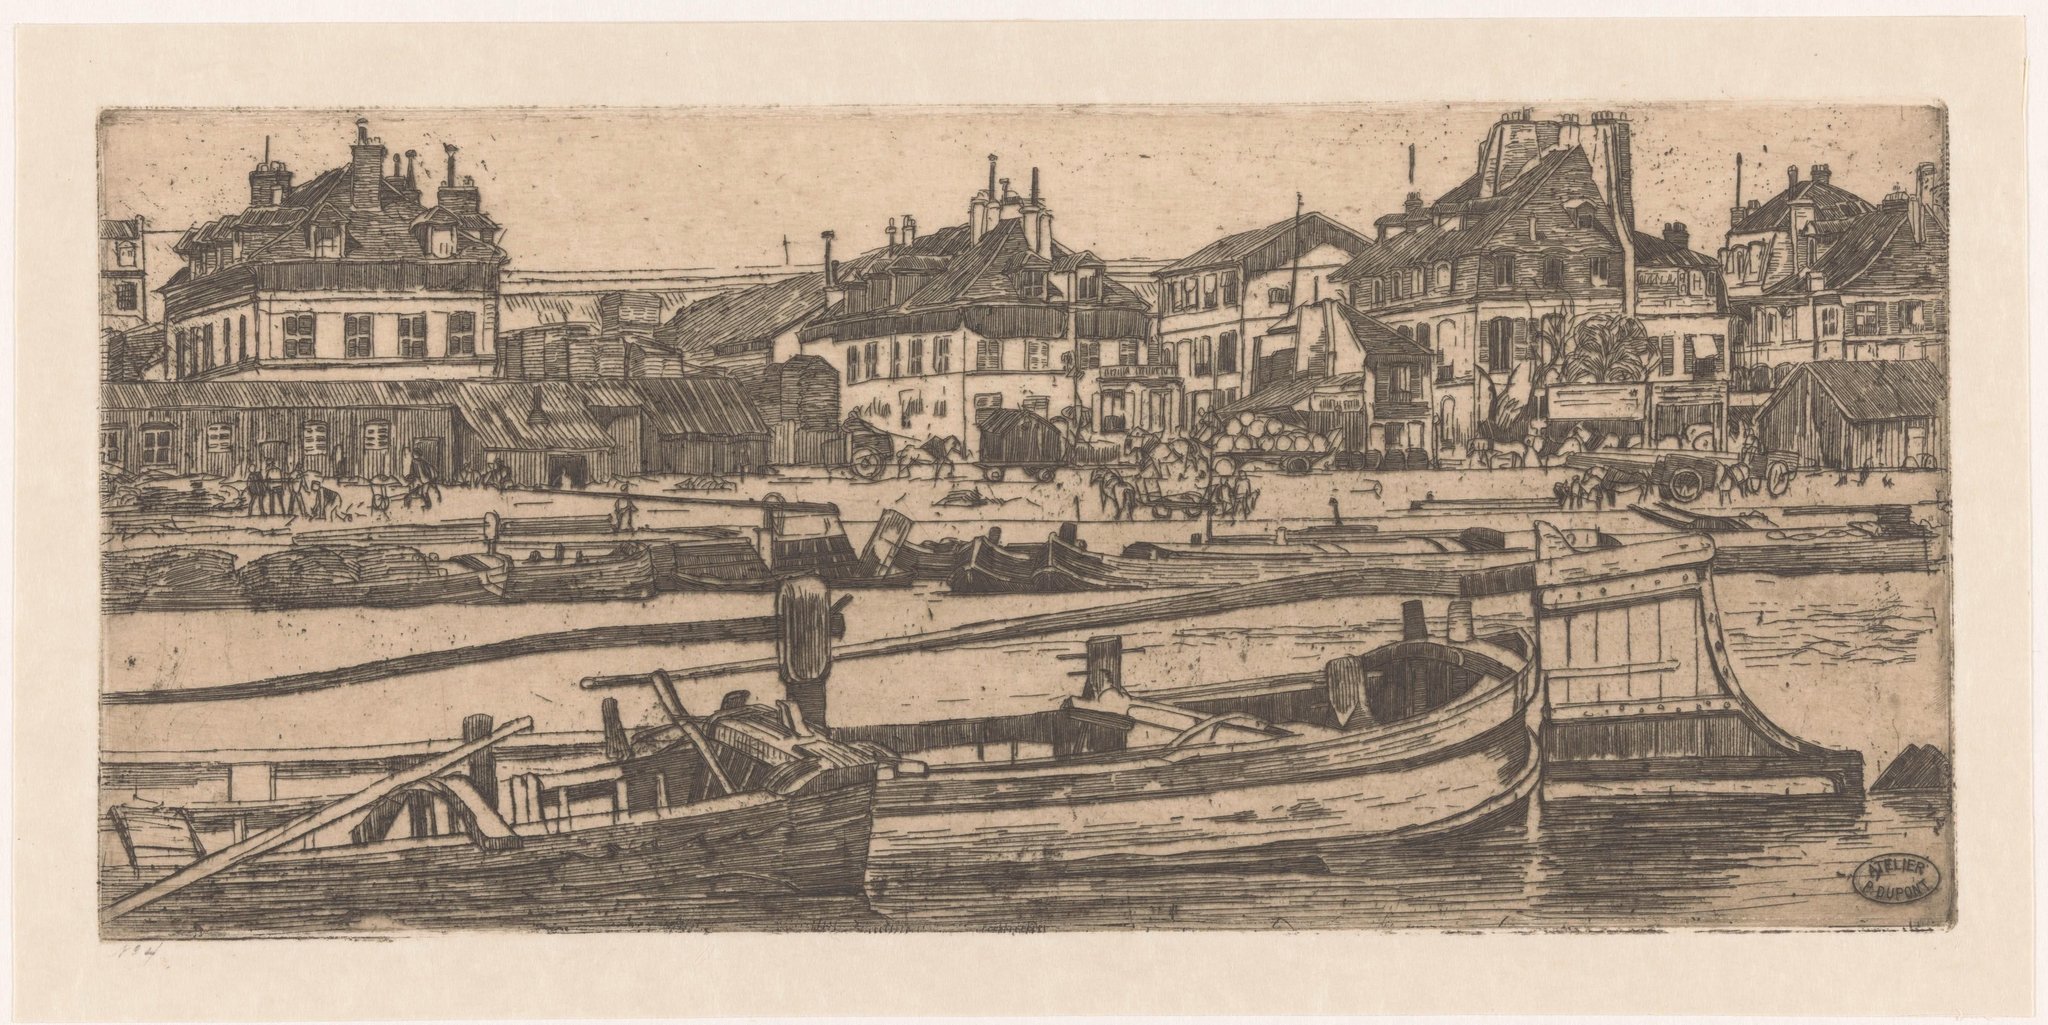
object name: print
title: Schuiten in de Seine in Parijs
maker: pieter dupont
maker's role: draughtsman, print maker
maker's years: 1870-1911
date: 1896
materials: paper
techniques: intaglio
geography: paris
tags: city-view, and landscape with man-made constructions, ships (in general), paris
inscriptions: workshop stamp: ‘ATELIER P. DUPONT’, number: ‘4’, collector's mark: Lugt 2233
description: Op de achtergrond huizen. Voor de huizen meerdere paarden, waarvan sommigen voor een rijtuig gespannen.